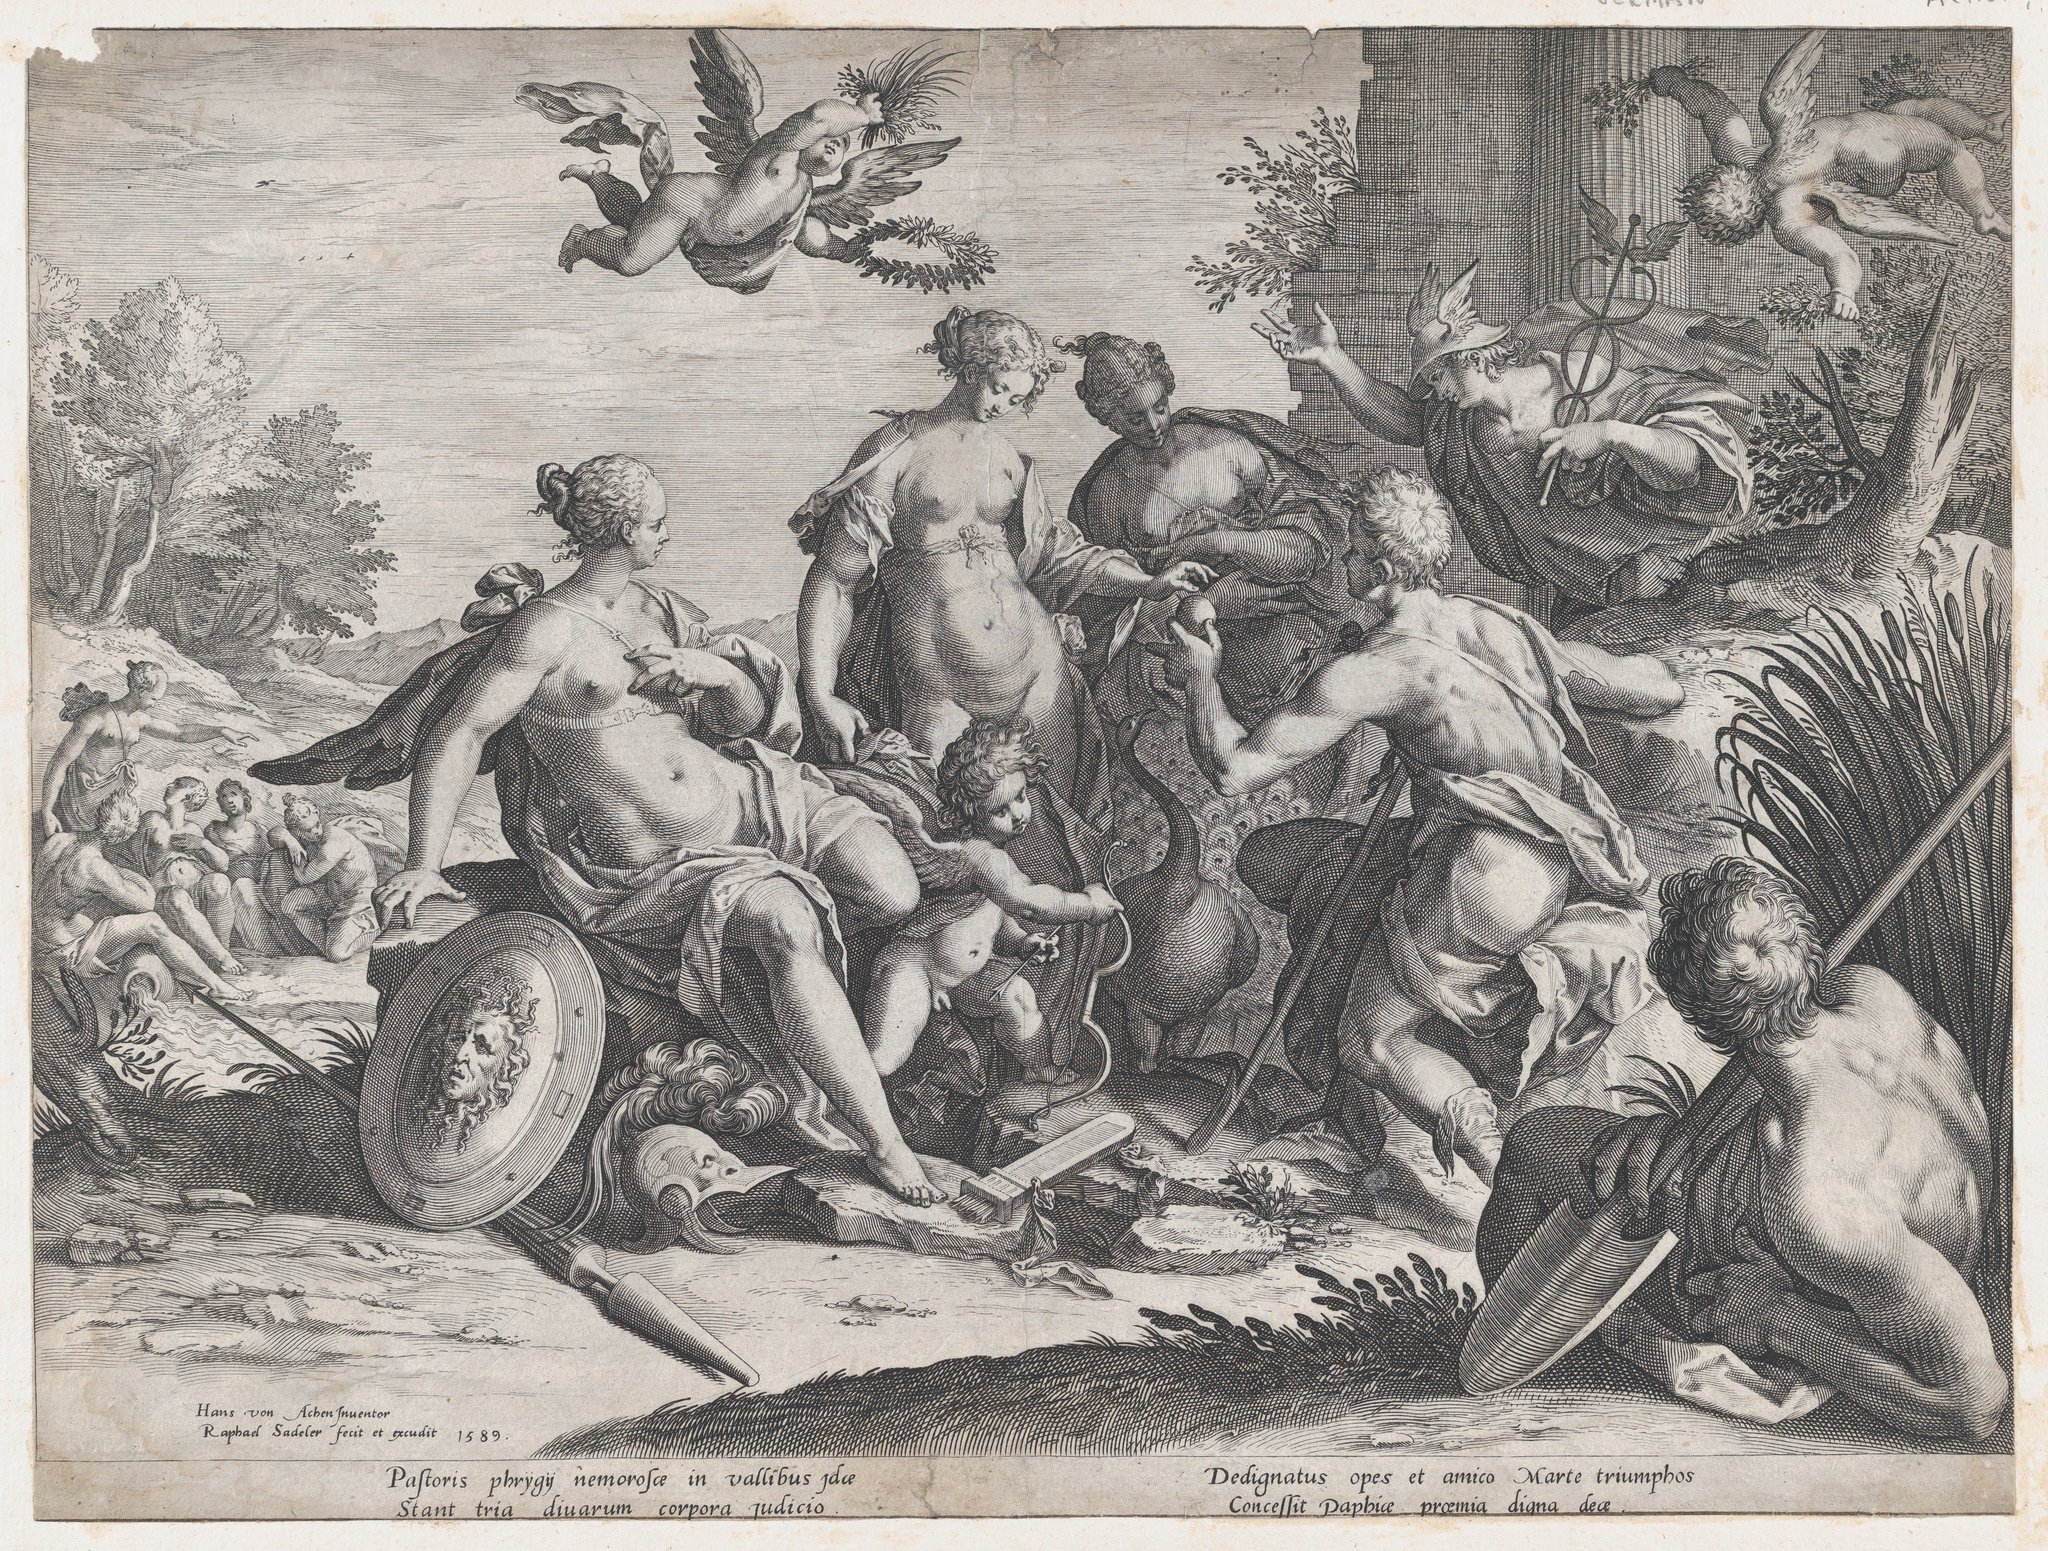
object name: print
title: The Judgement of Paris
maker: raphael sadeler i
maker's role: artist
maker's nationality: netherlandish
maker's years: 1560-1628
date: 1589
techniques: engraving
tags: aphrodite,athena,peacocks,paris